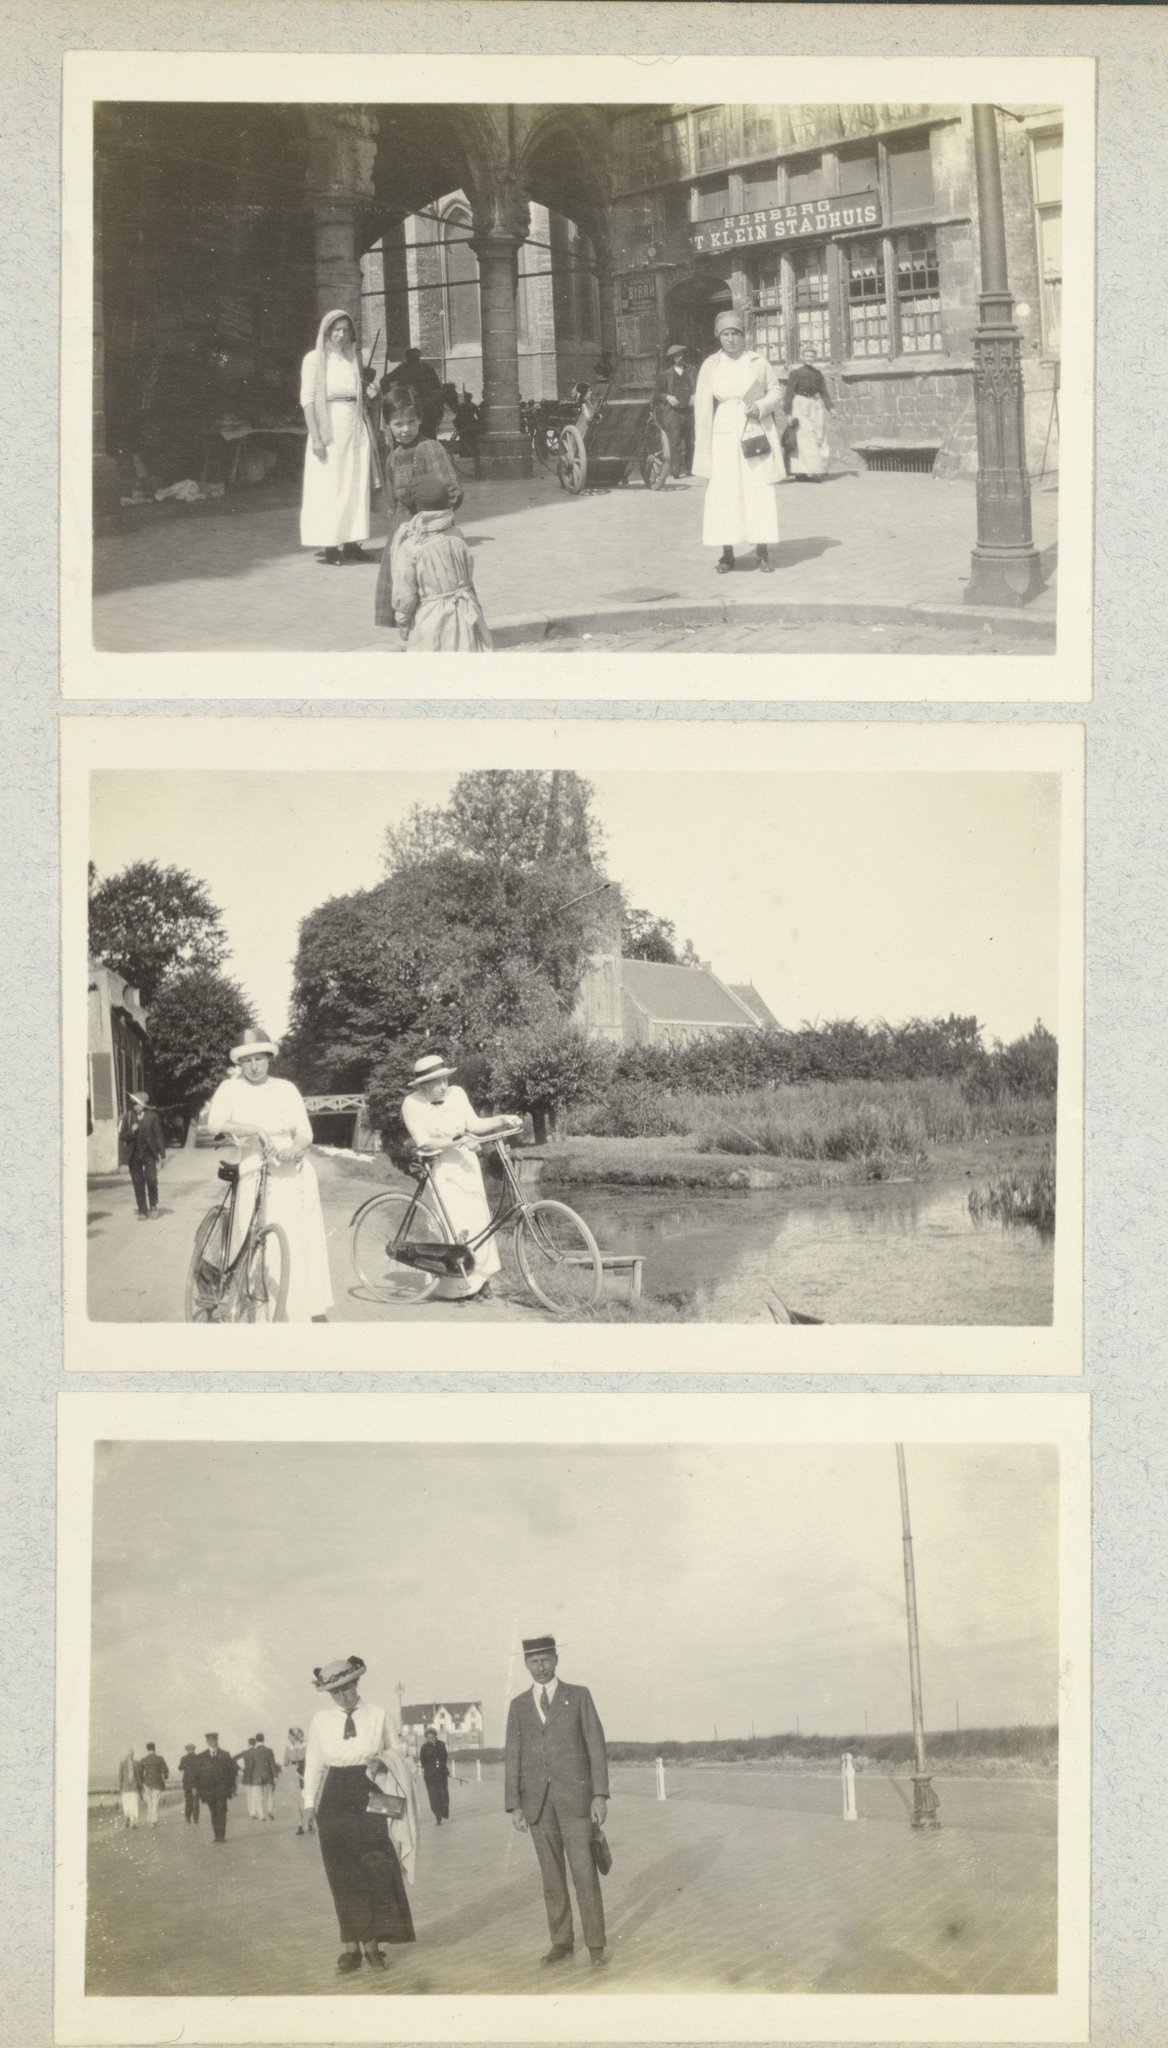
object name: photograph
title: Albumblad met drie foto's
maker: andries augustus boom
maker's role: amateurfotograaf, handelaar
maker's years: 1878-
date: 1912-1914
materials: paper, photographic support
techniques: photography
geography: netherlands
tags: amsterdam, andries augustus boom, netherlands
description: Albumblad met drie foto's in Nederland. Onderdeel van het fotoalbum van de familie Boom-Gonggrijp in Suriname en Curaçao.